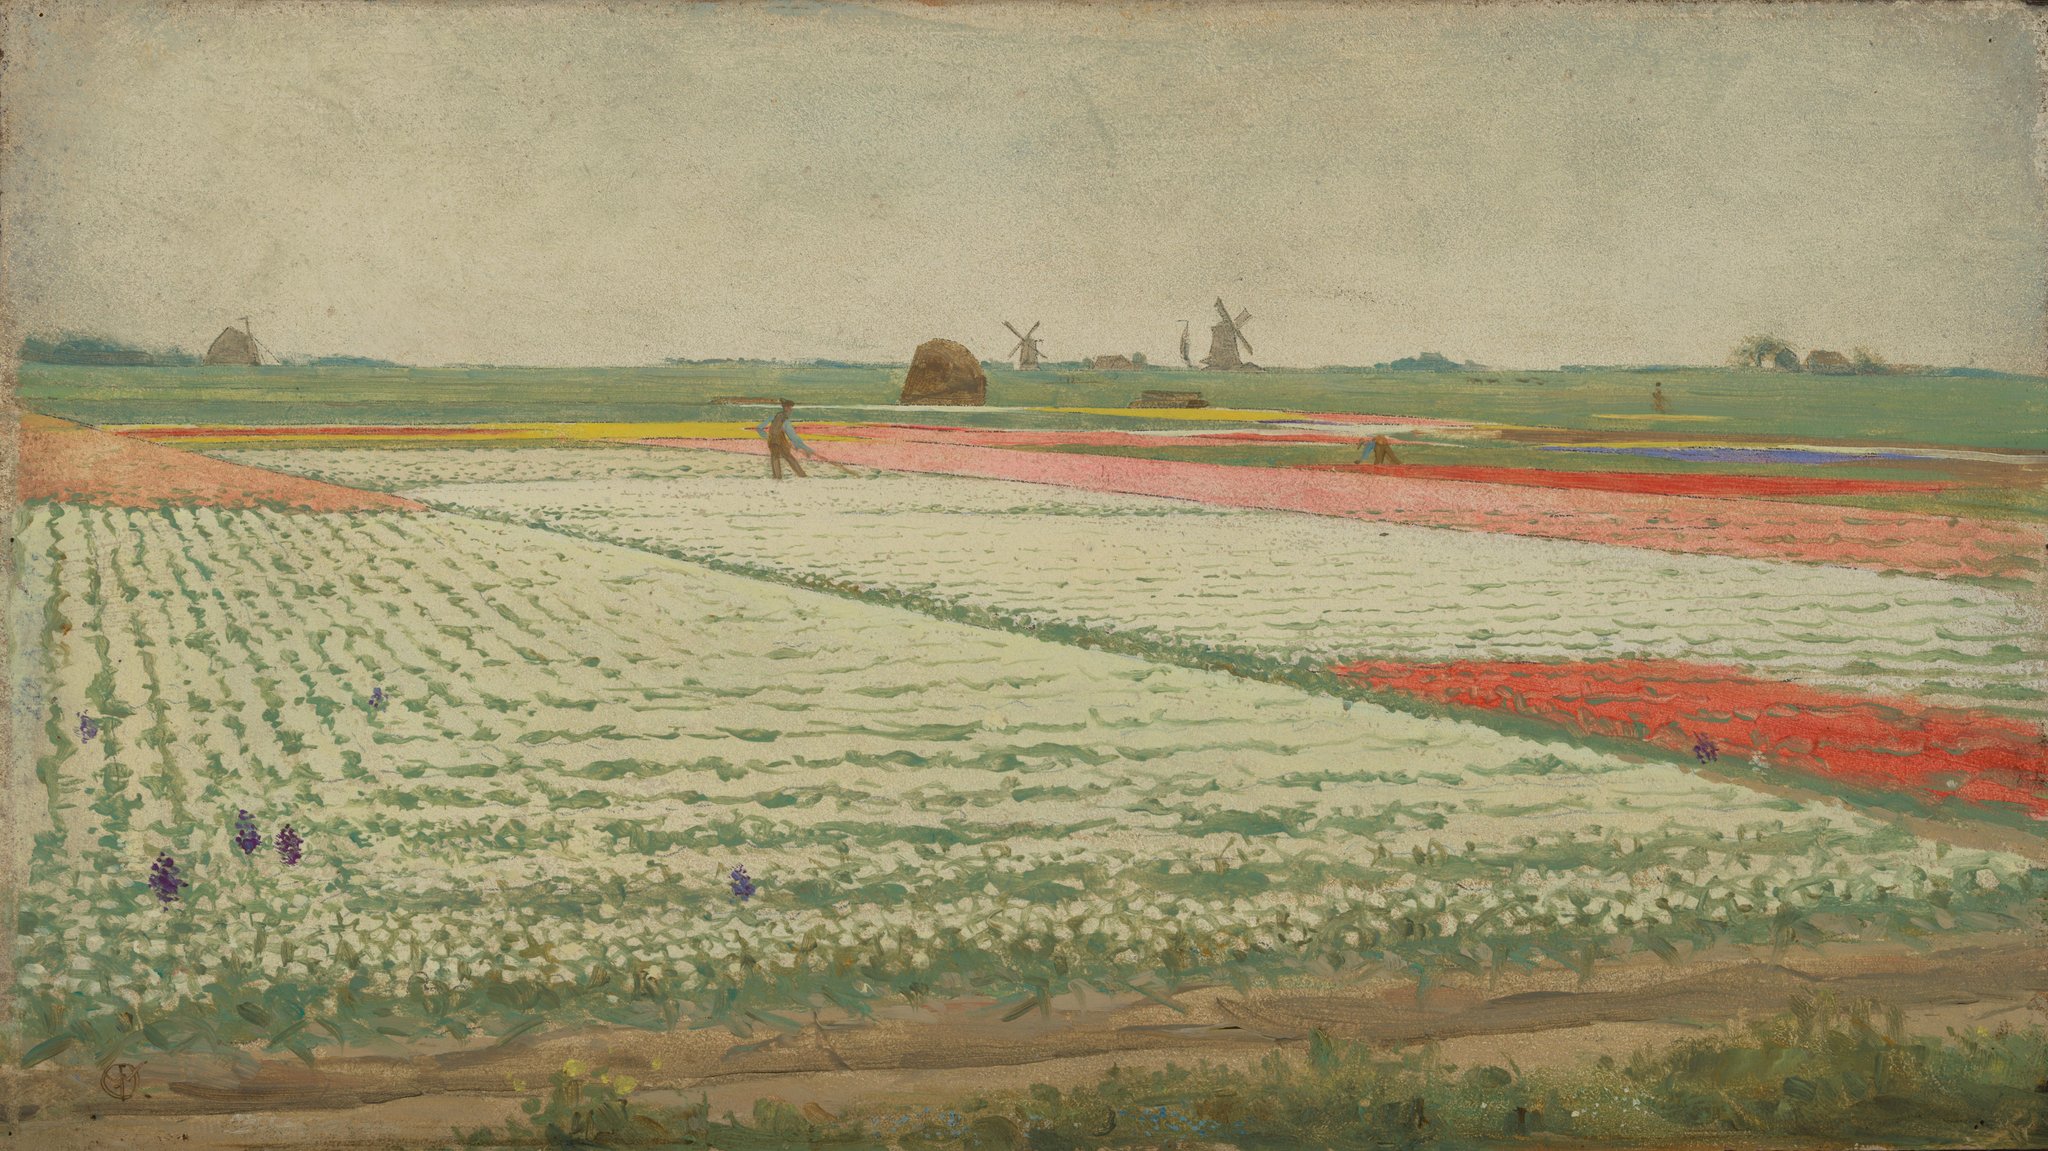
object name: painting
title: Tulip Fields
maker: gerrit willem dijsselhof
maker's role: designer, draughtsman, print maker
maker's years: 1866-1924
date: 1890-1922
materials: oil, panel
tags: flowers, field filled with a crop, bulb field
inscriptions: signature: ‘GWD’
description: Tulpenvelden. Gezicht over tulpenvelden in de Bollenstreek. In de verte enkele arbeiders, aan de horizon windmolens.